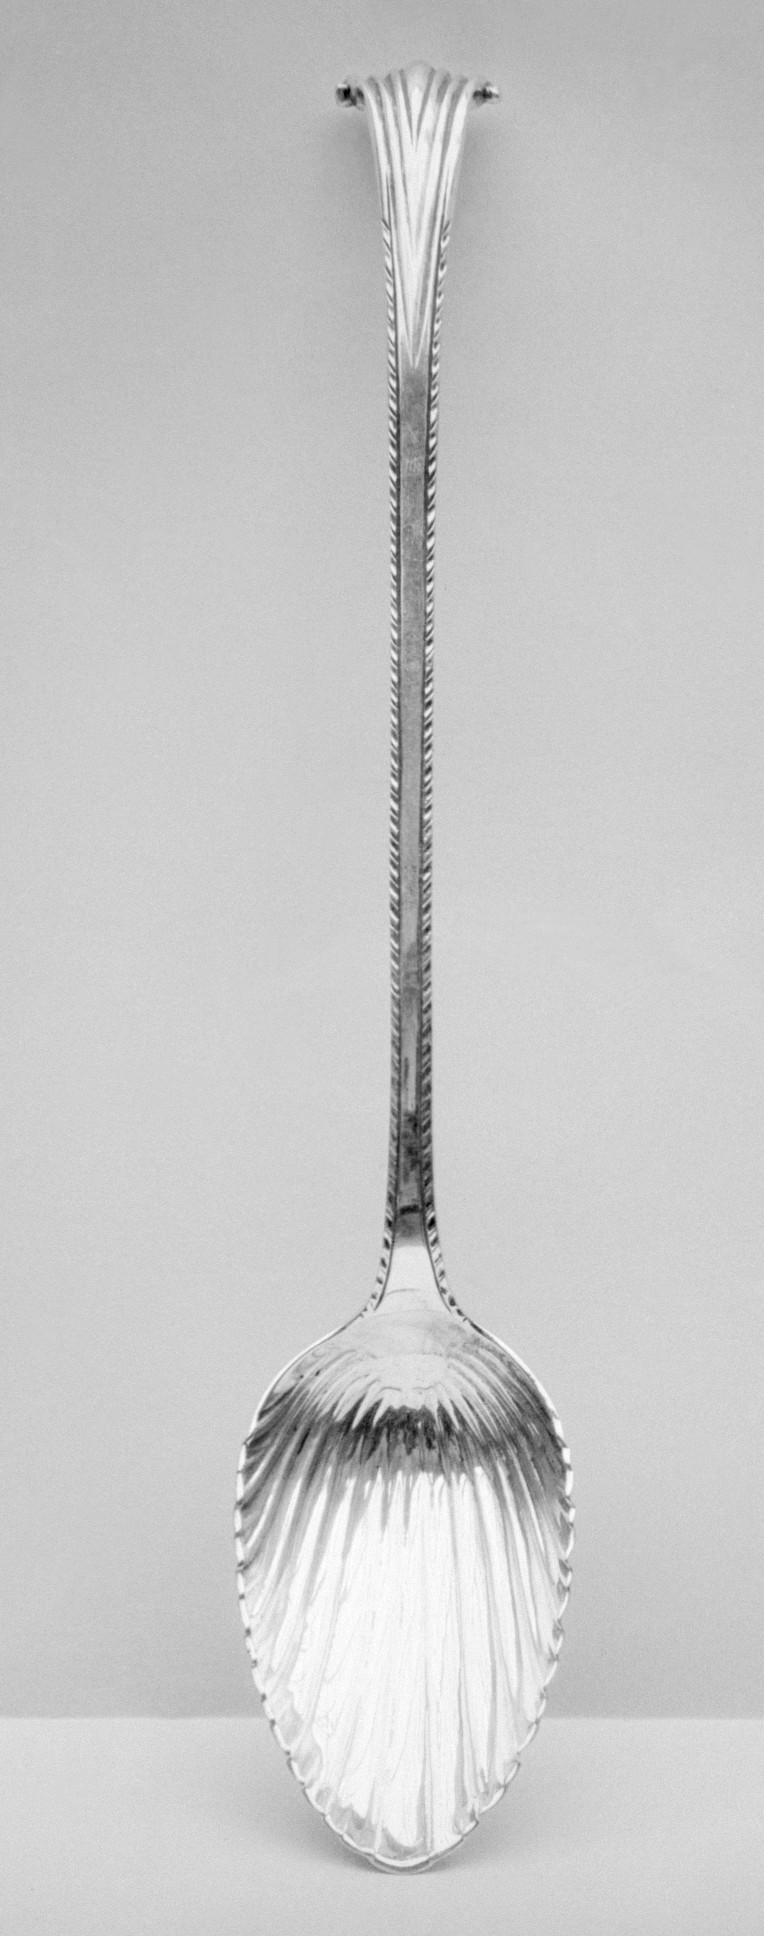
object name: spoon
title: Serving spoon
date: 1789-1790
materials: silver